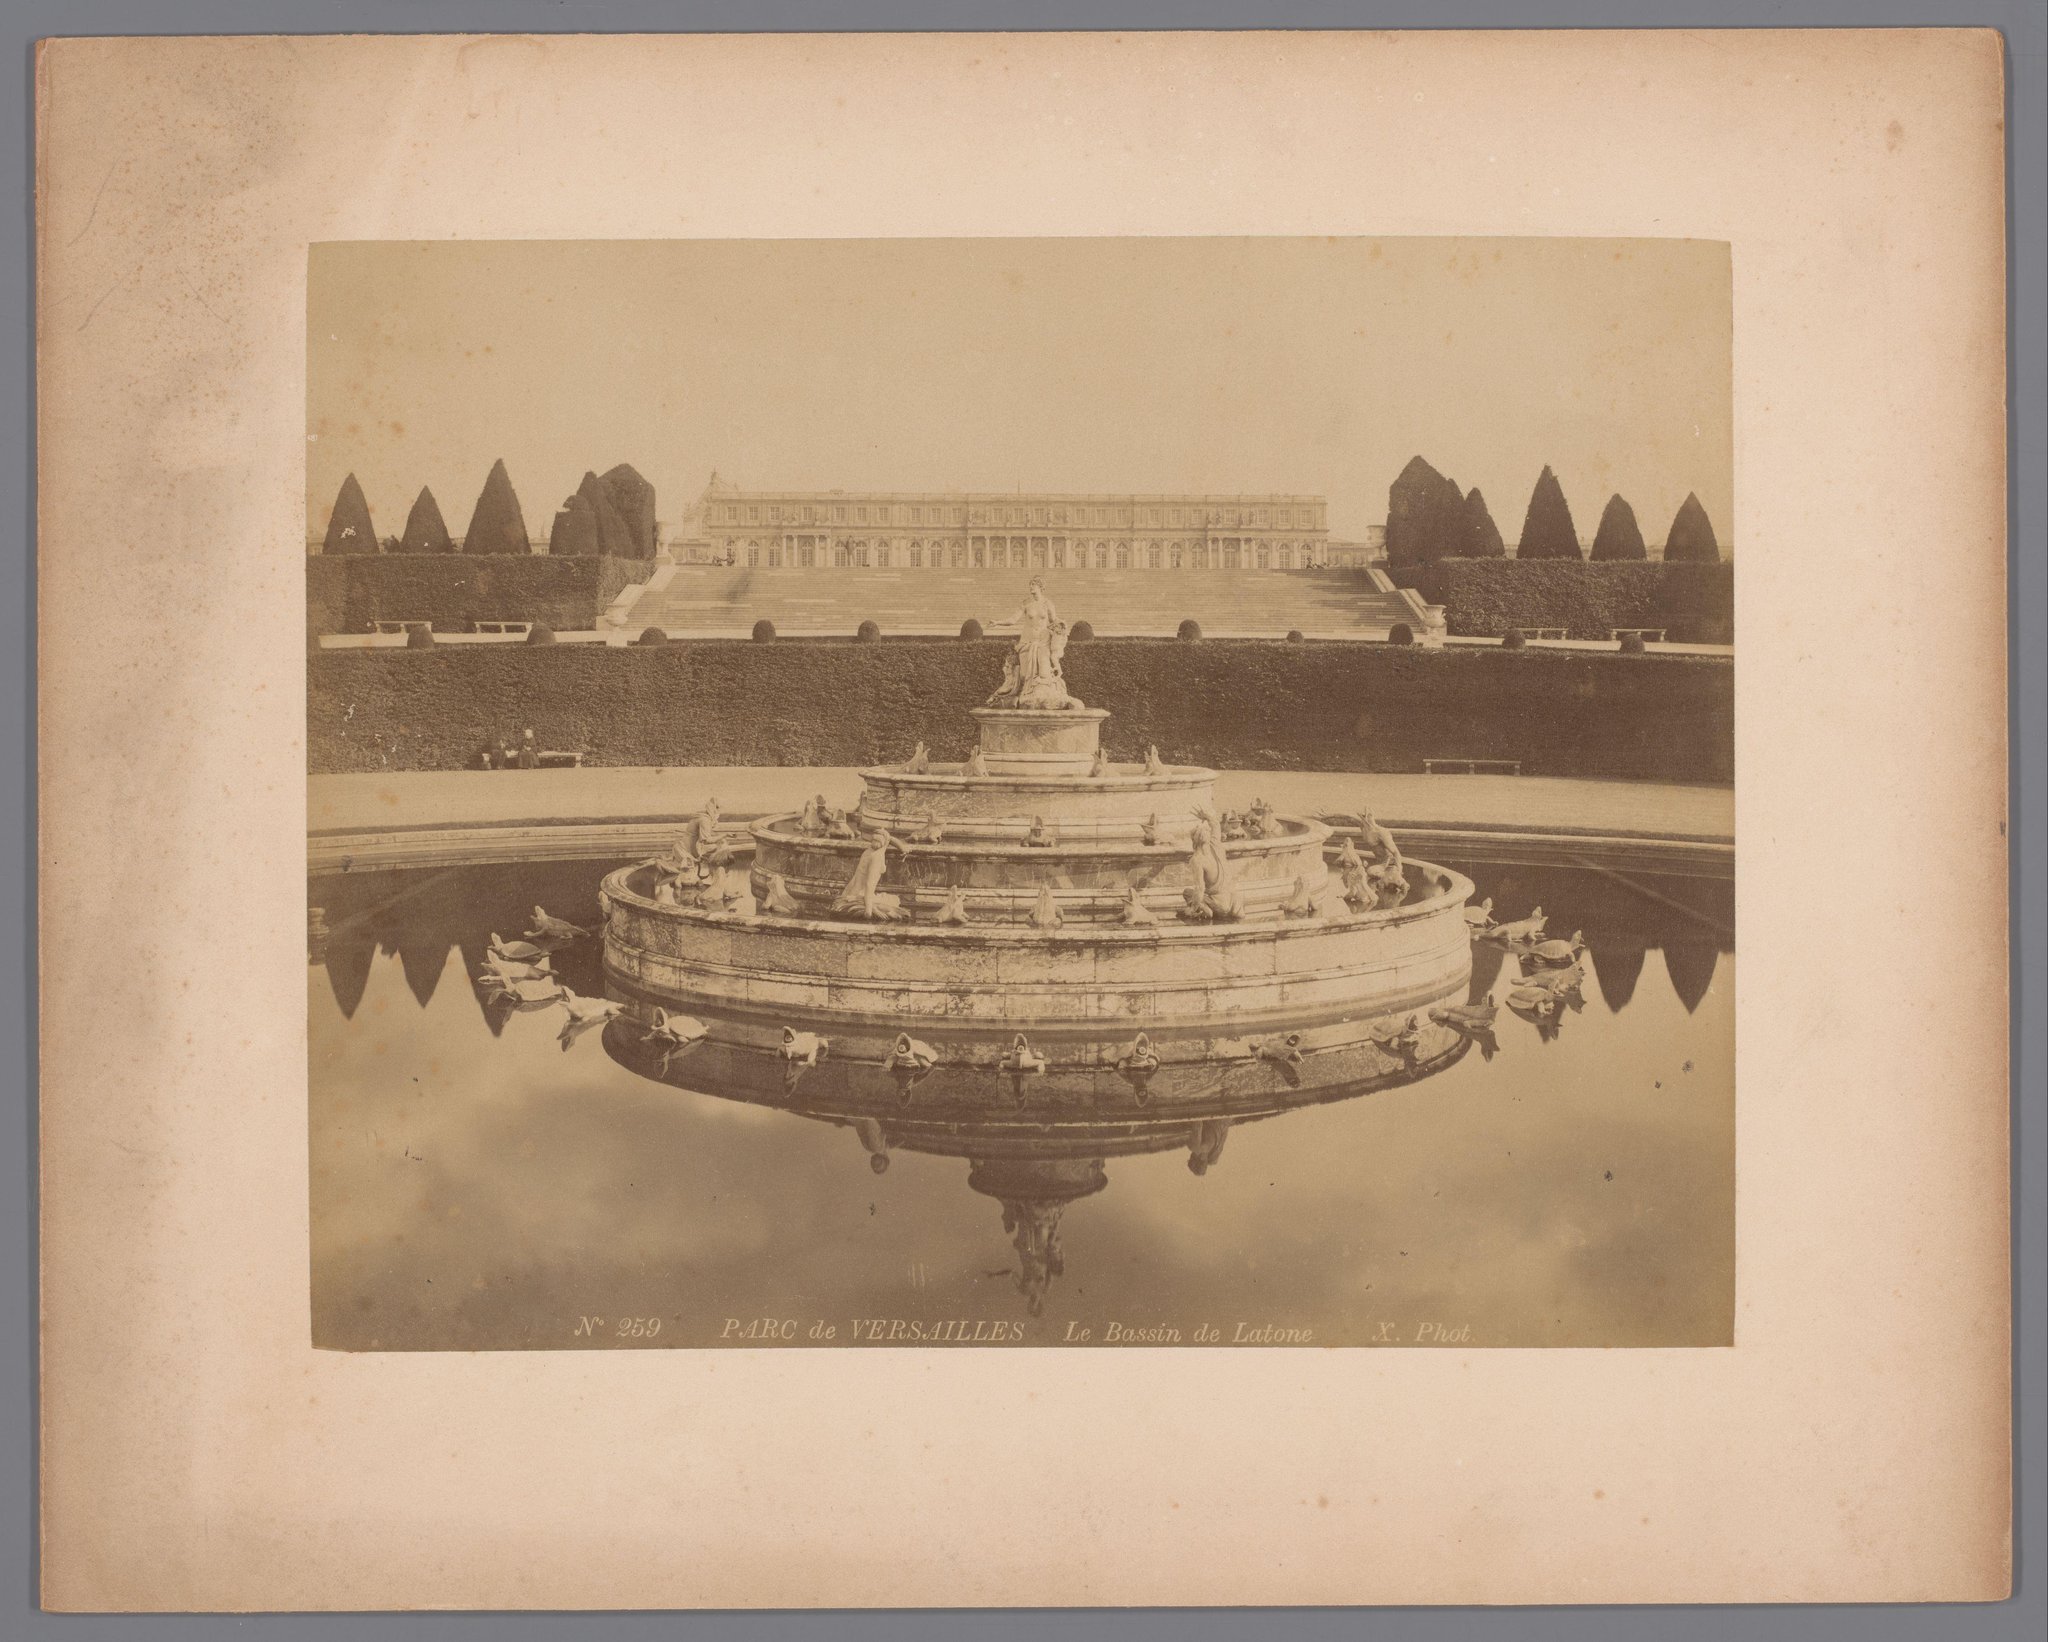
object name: photograph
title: Vijver "La Bassin de Latone", Park van Paleis van Versailles, Frankrijk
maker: Anonymous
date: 1880-1910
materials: cardboard, photographic support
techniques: albumen print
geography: france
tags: versailles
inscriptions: caption: ‘No. 259 PARC de VERSAILLES Le Bassin de Latone//X. Phot.’